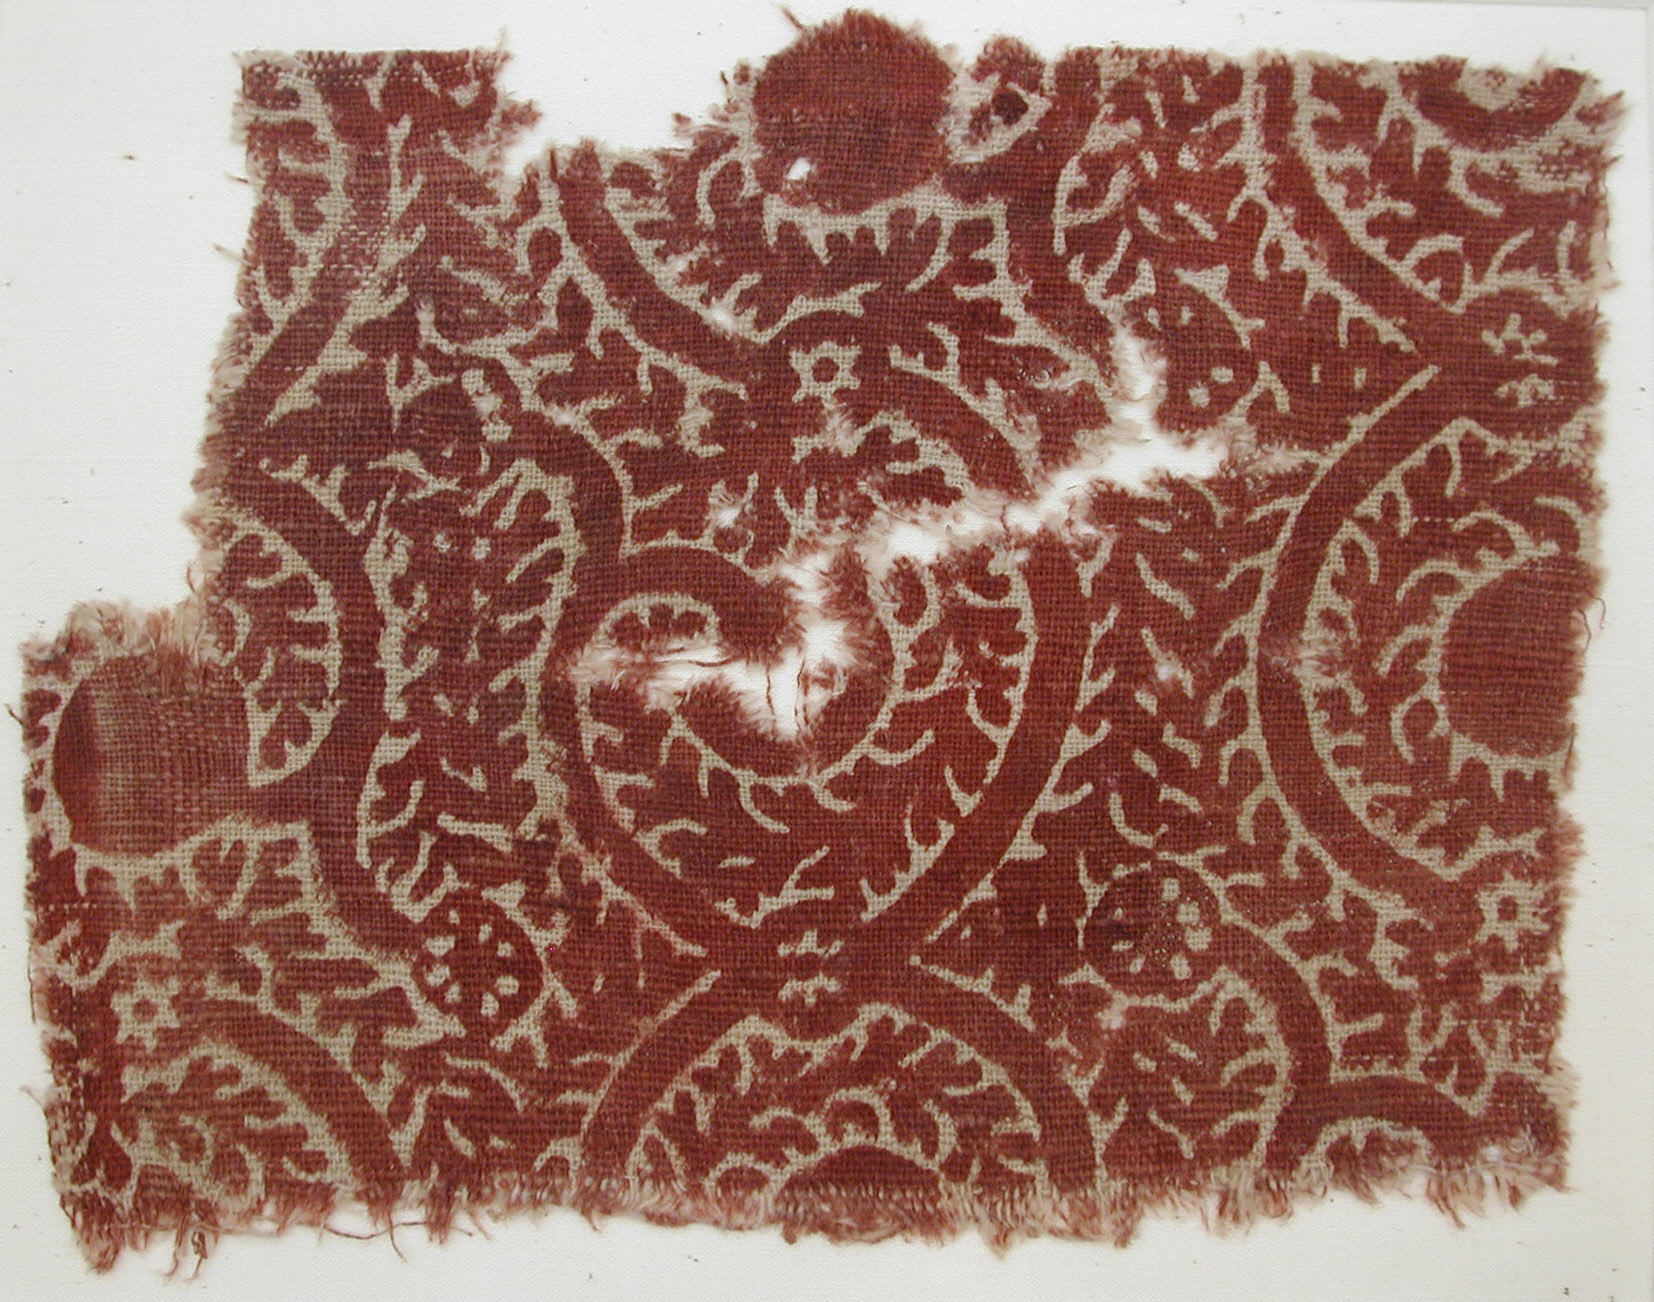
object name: textile fragment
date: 1301-1500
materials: cotton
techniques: dyeing, weave, printing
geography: egypt